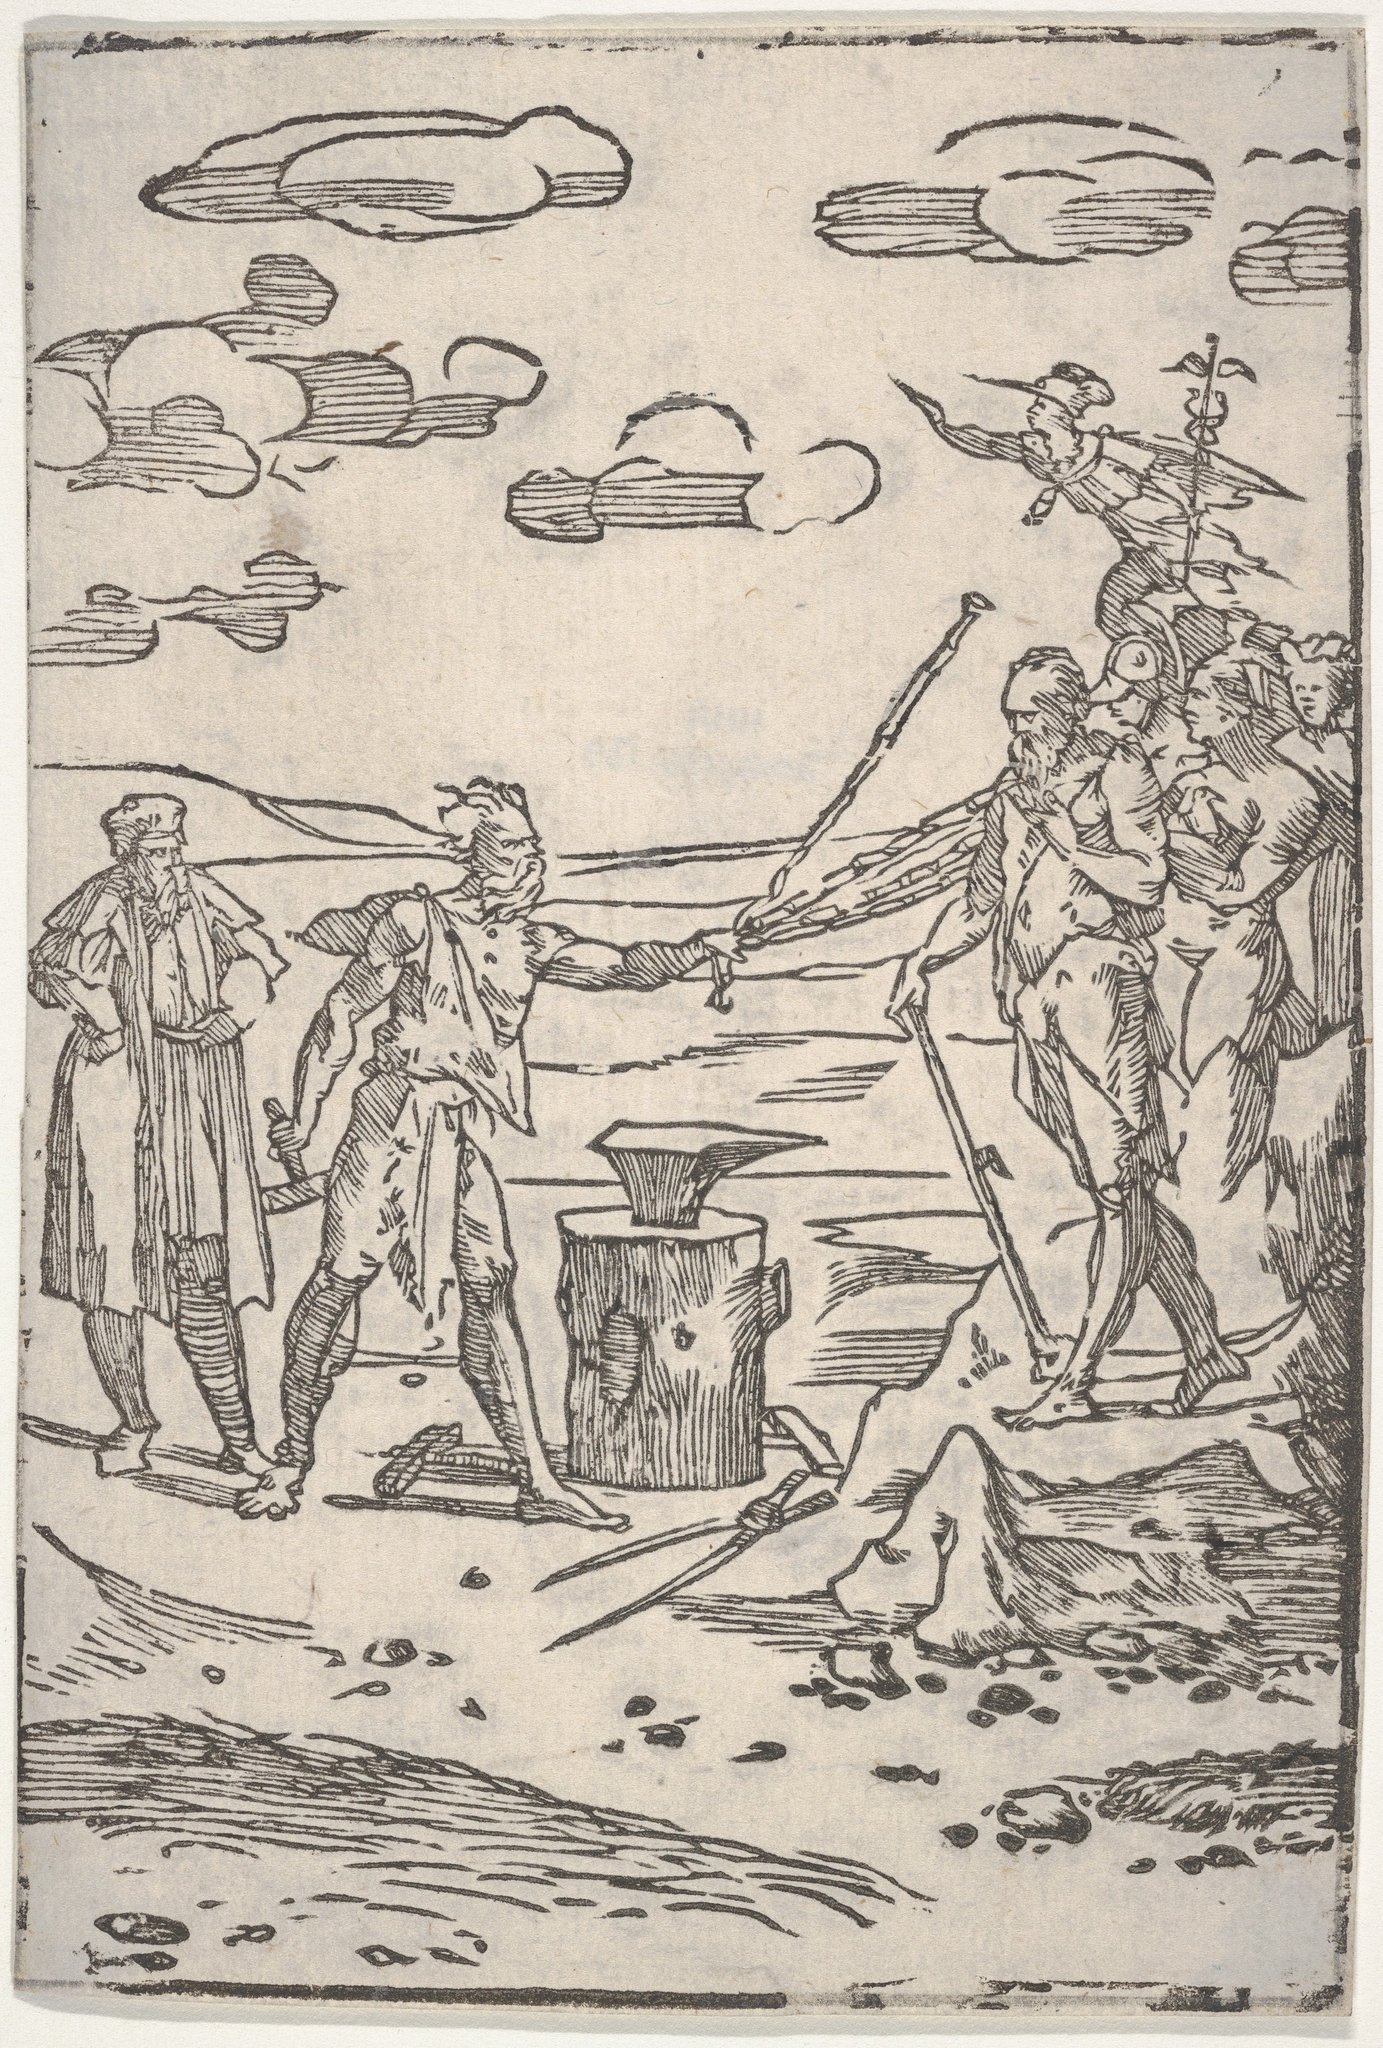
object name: print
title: The forger standing by an anvil pulling a man in chains, from "The various operations of alchemy"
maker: domenico beccafumi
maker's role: artist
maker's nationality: italian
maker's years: 1484-1551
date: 1540-1550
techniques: woodcut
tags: prisoners,men